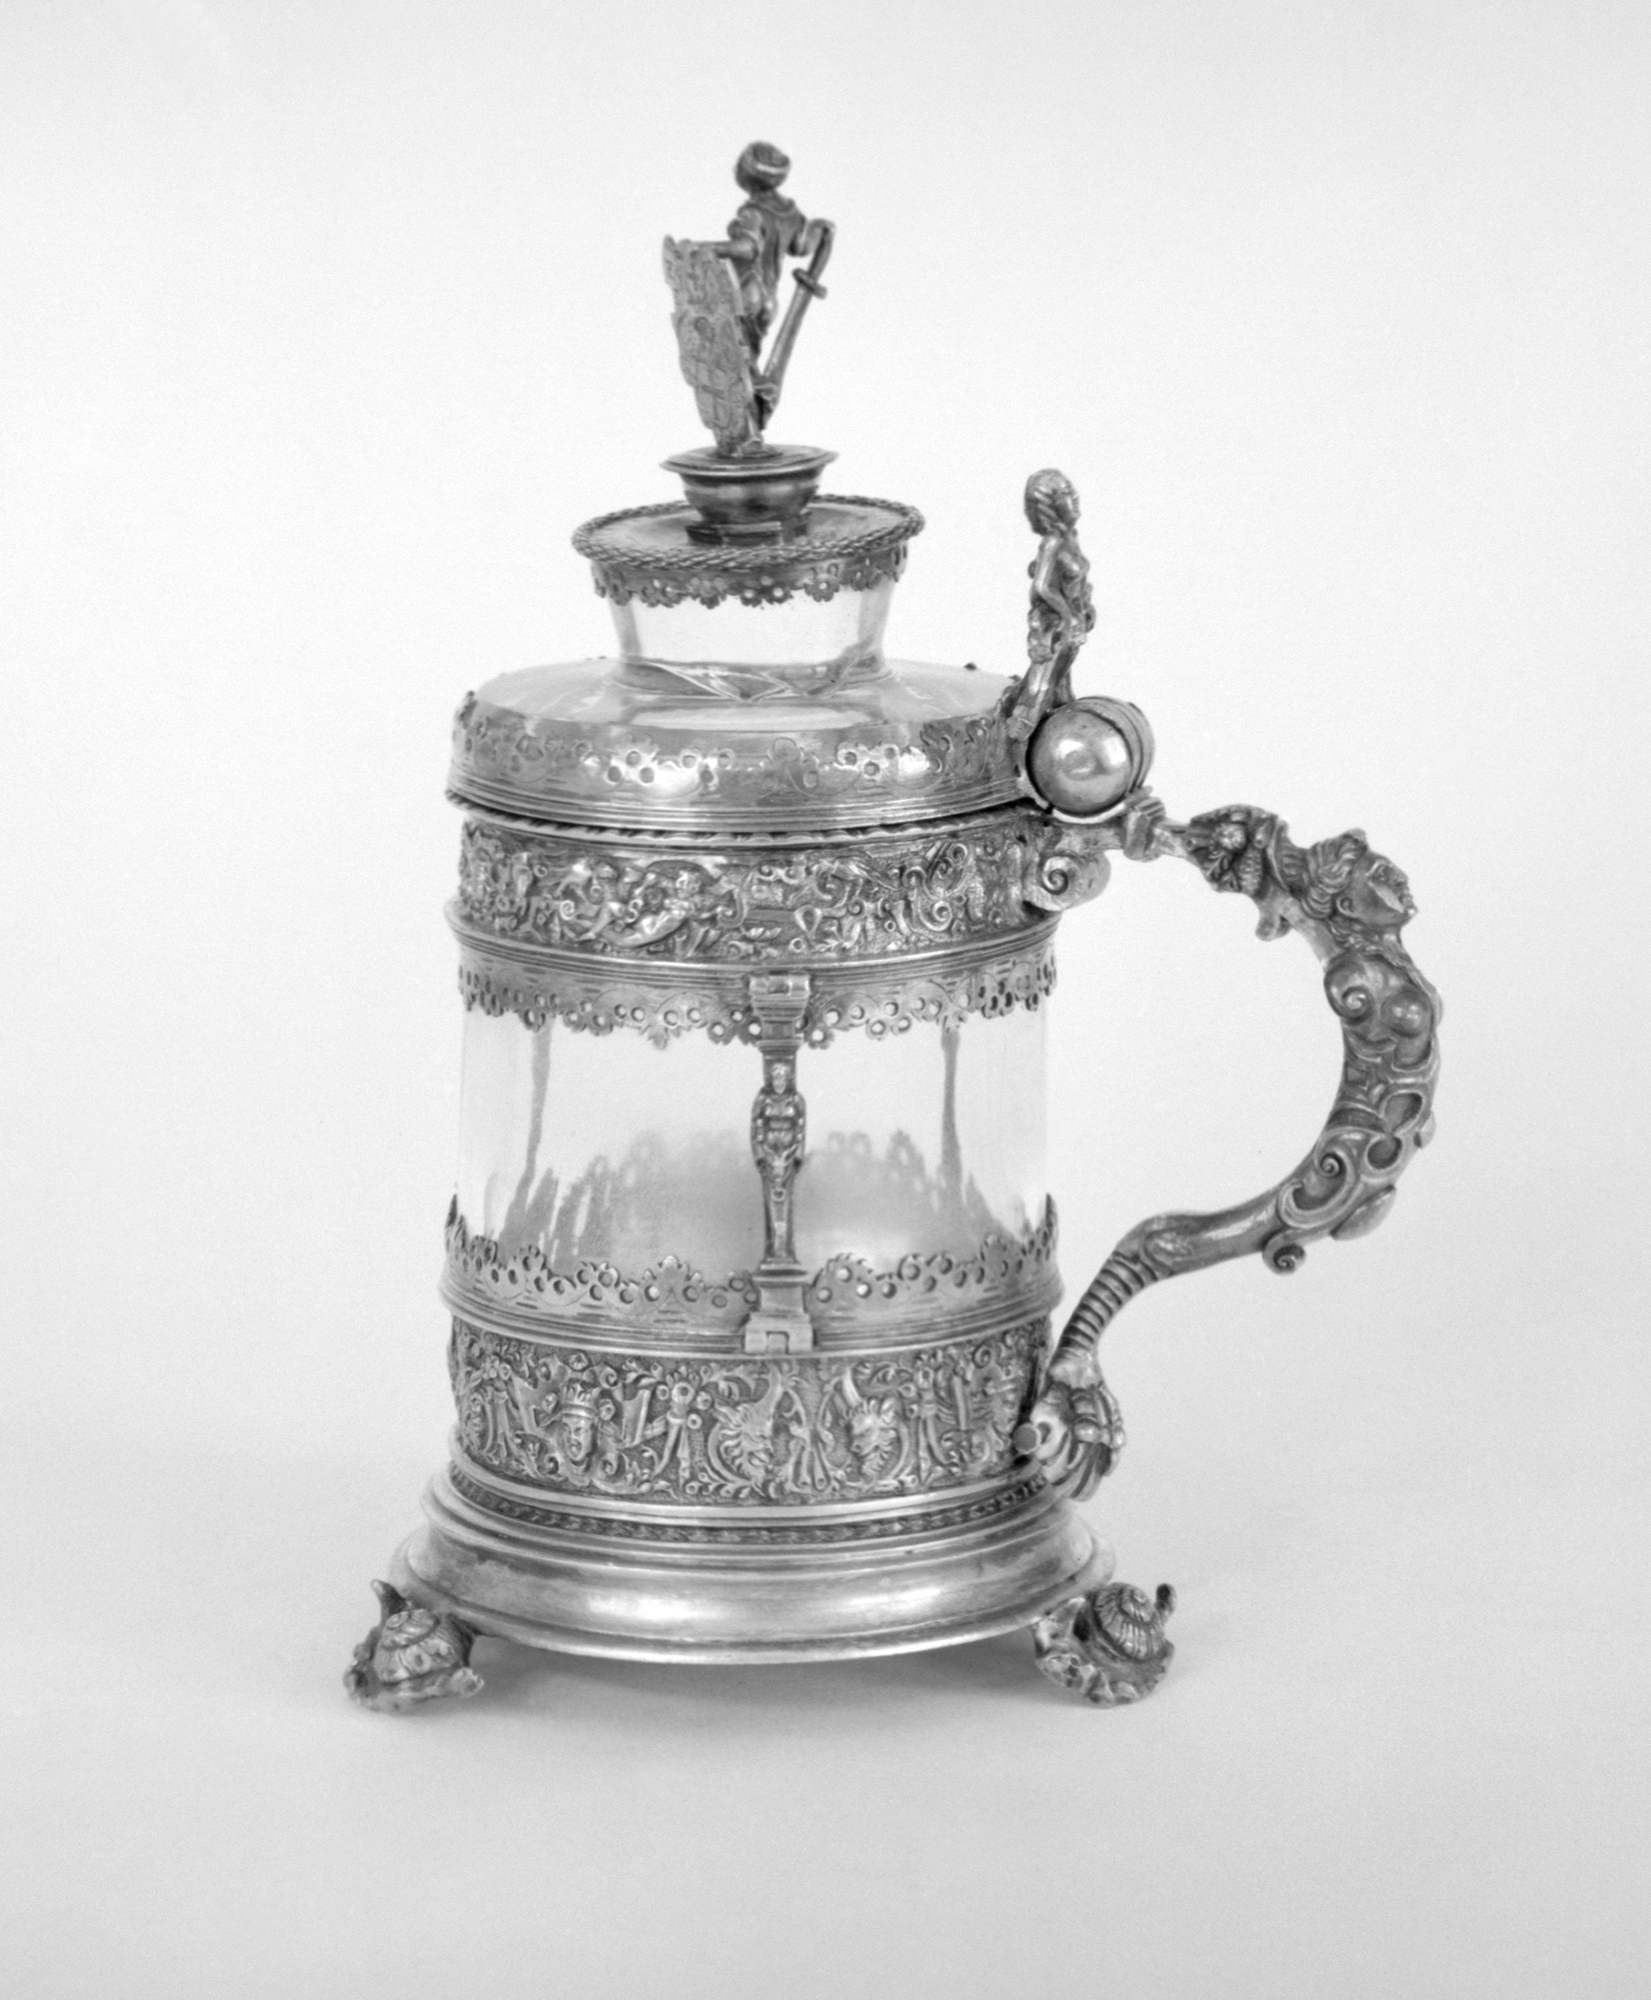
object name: tankard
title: Tankard inset with rock crystal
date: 1580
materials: quartz, silver gilt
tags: faces,men